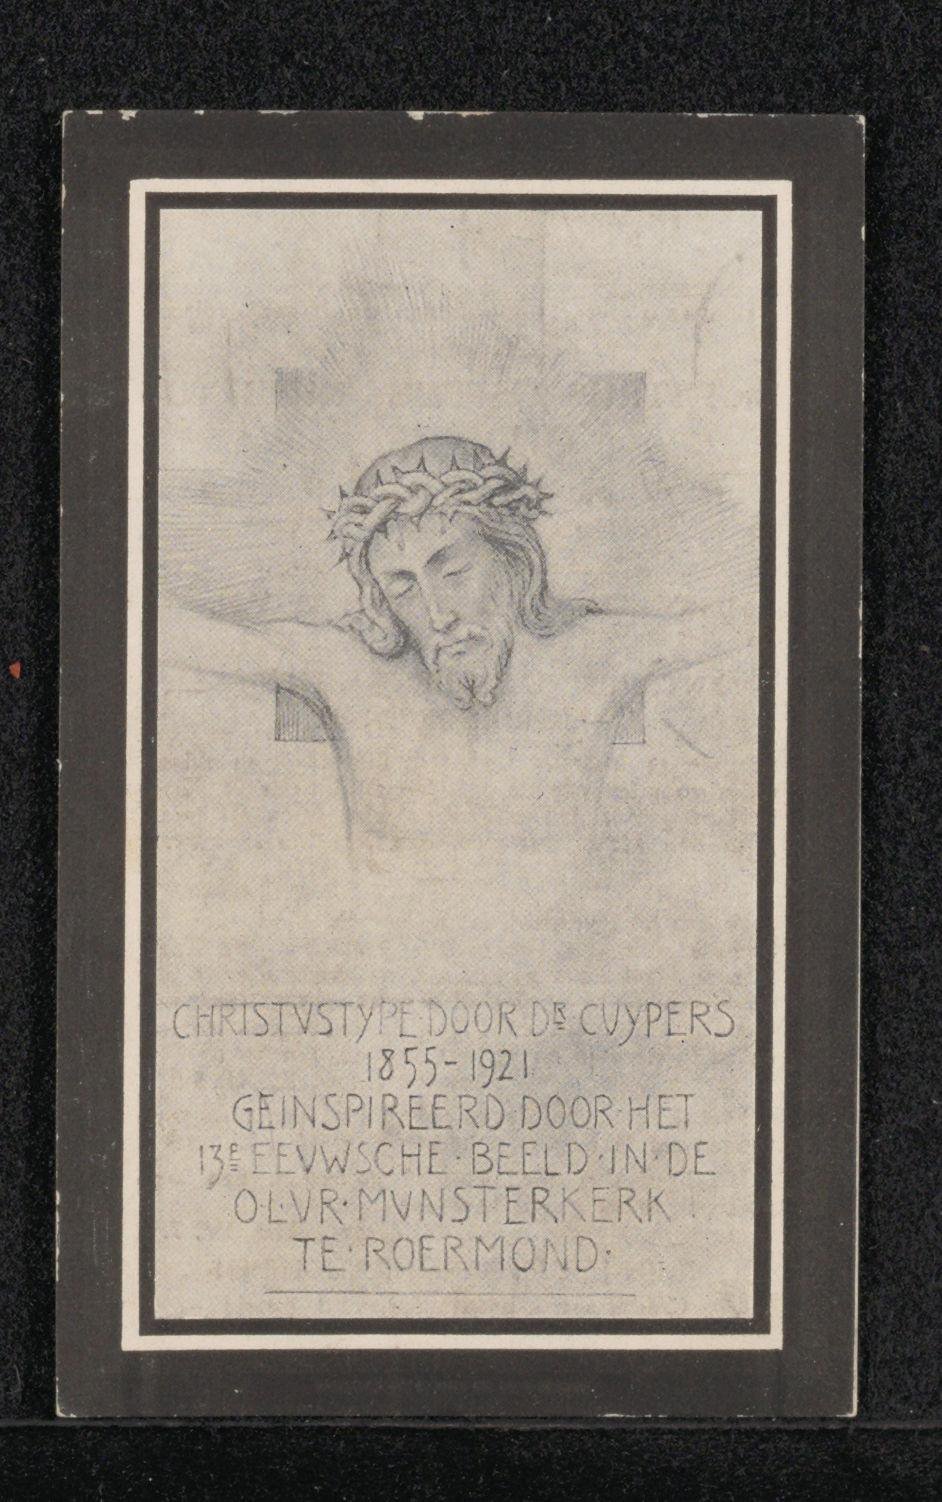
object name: doodsprent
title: Doodsprent Pierre Joseph Hubert Cuypers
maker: Anonymous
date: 1921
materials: cardboard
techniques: printing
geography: roermond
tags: draughtsman, pierre joseph hubert cuypers, christ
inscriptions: collector's mark: ‘RPK’